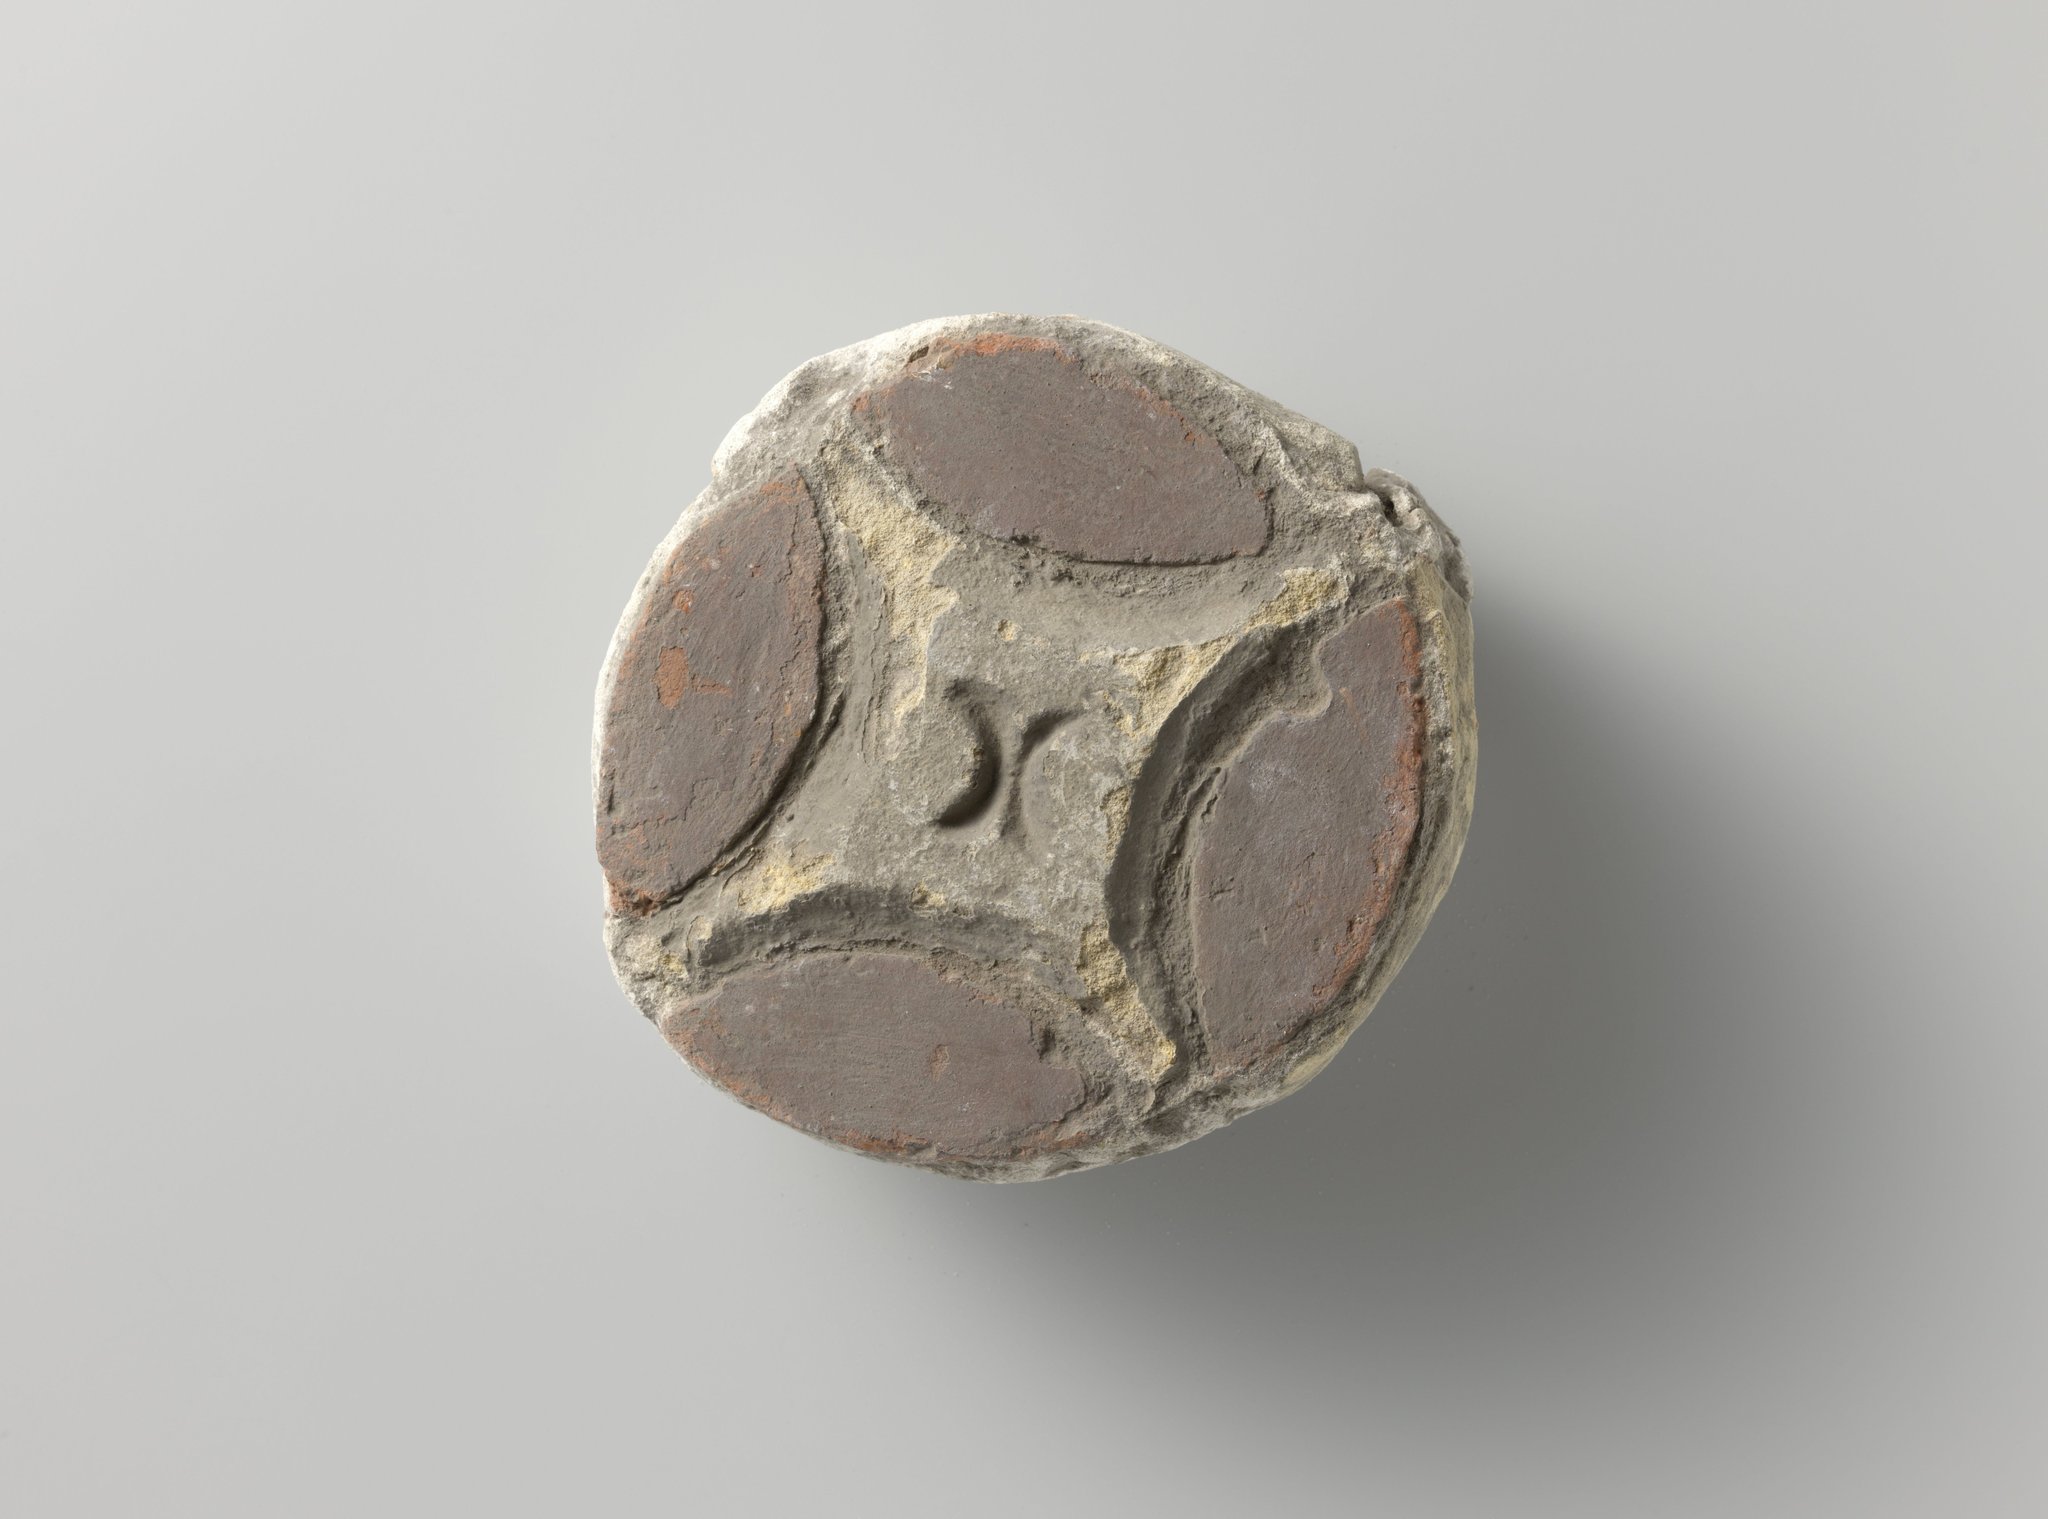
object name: gevelversiering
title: Drie fragmenten van een gevelversiering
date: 1400-1950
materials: stone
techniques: firing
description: Drie stukken van een gevelversiering. Ornamenten van zandsteen met stukken rode gebakken steen.